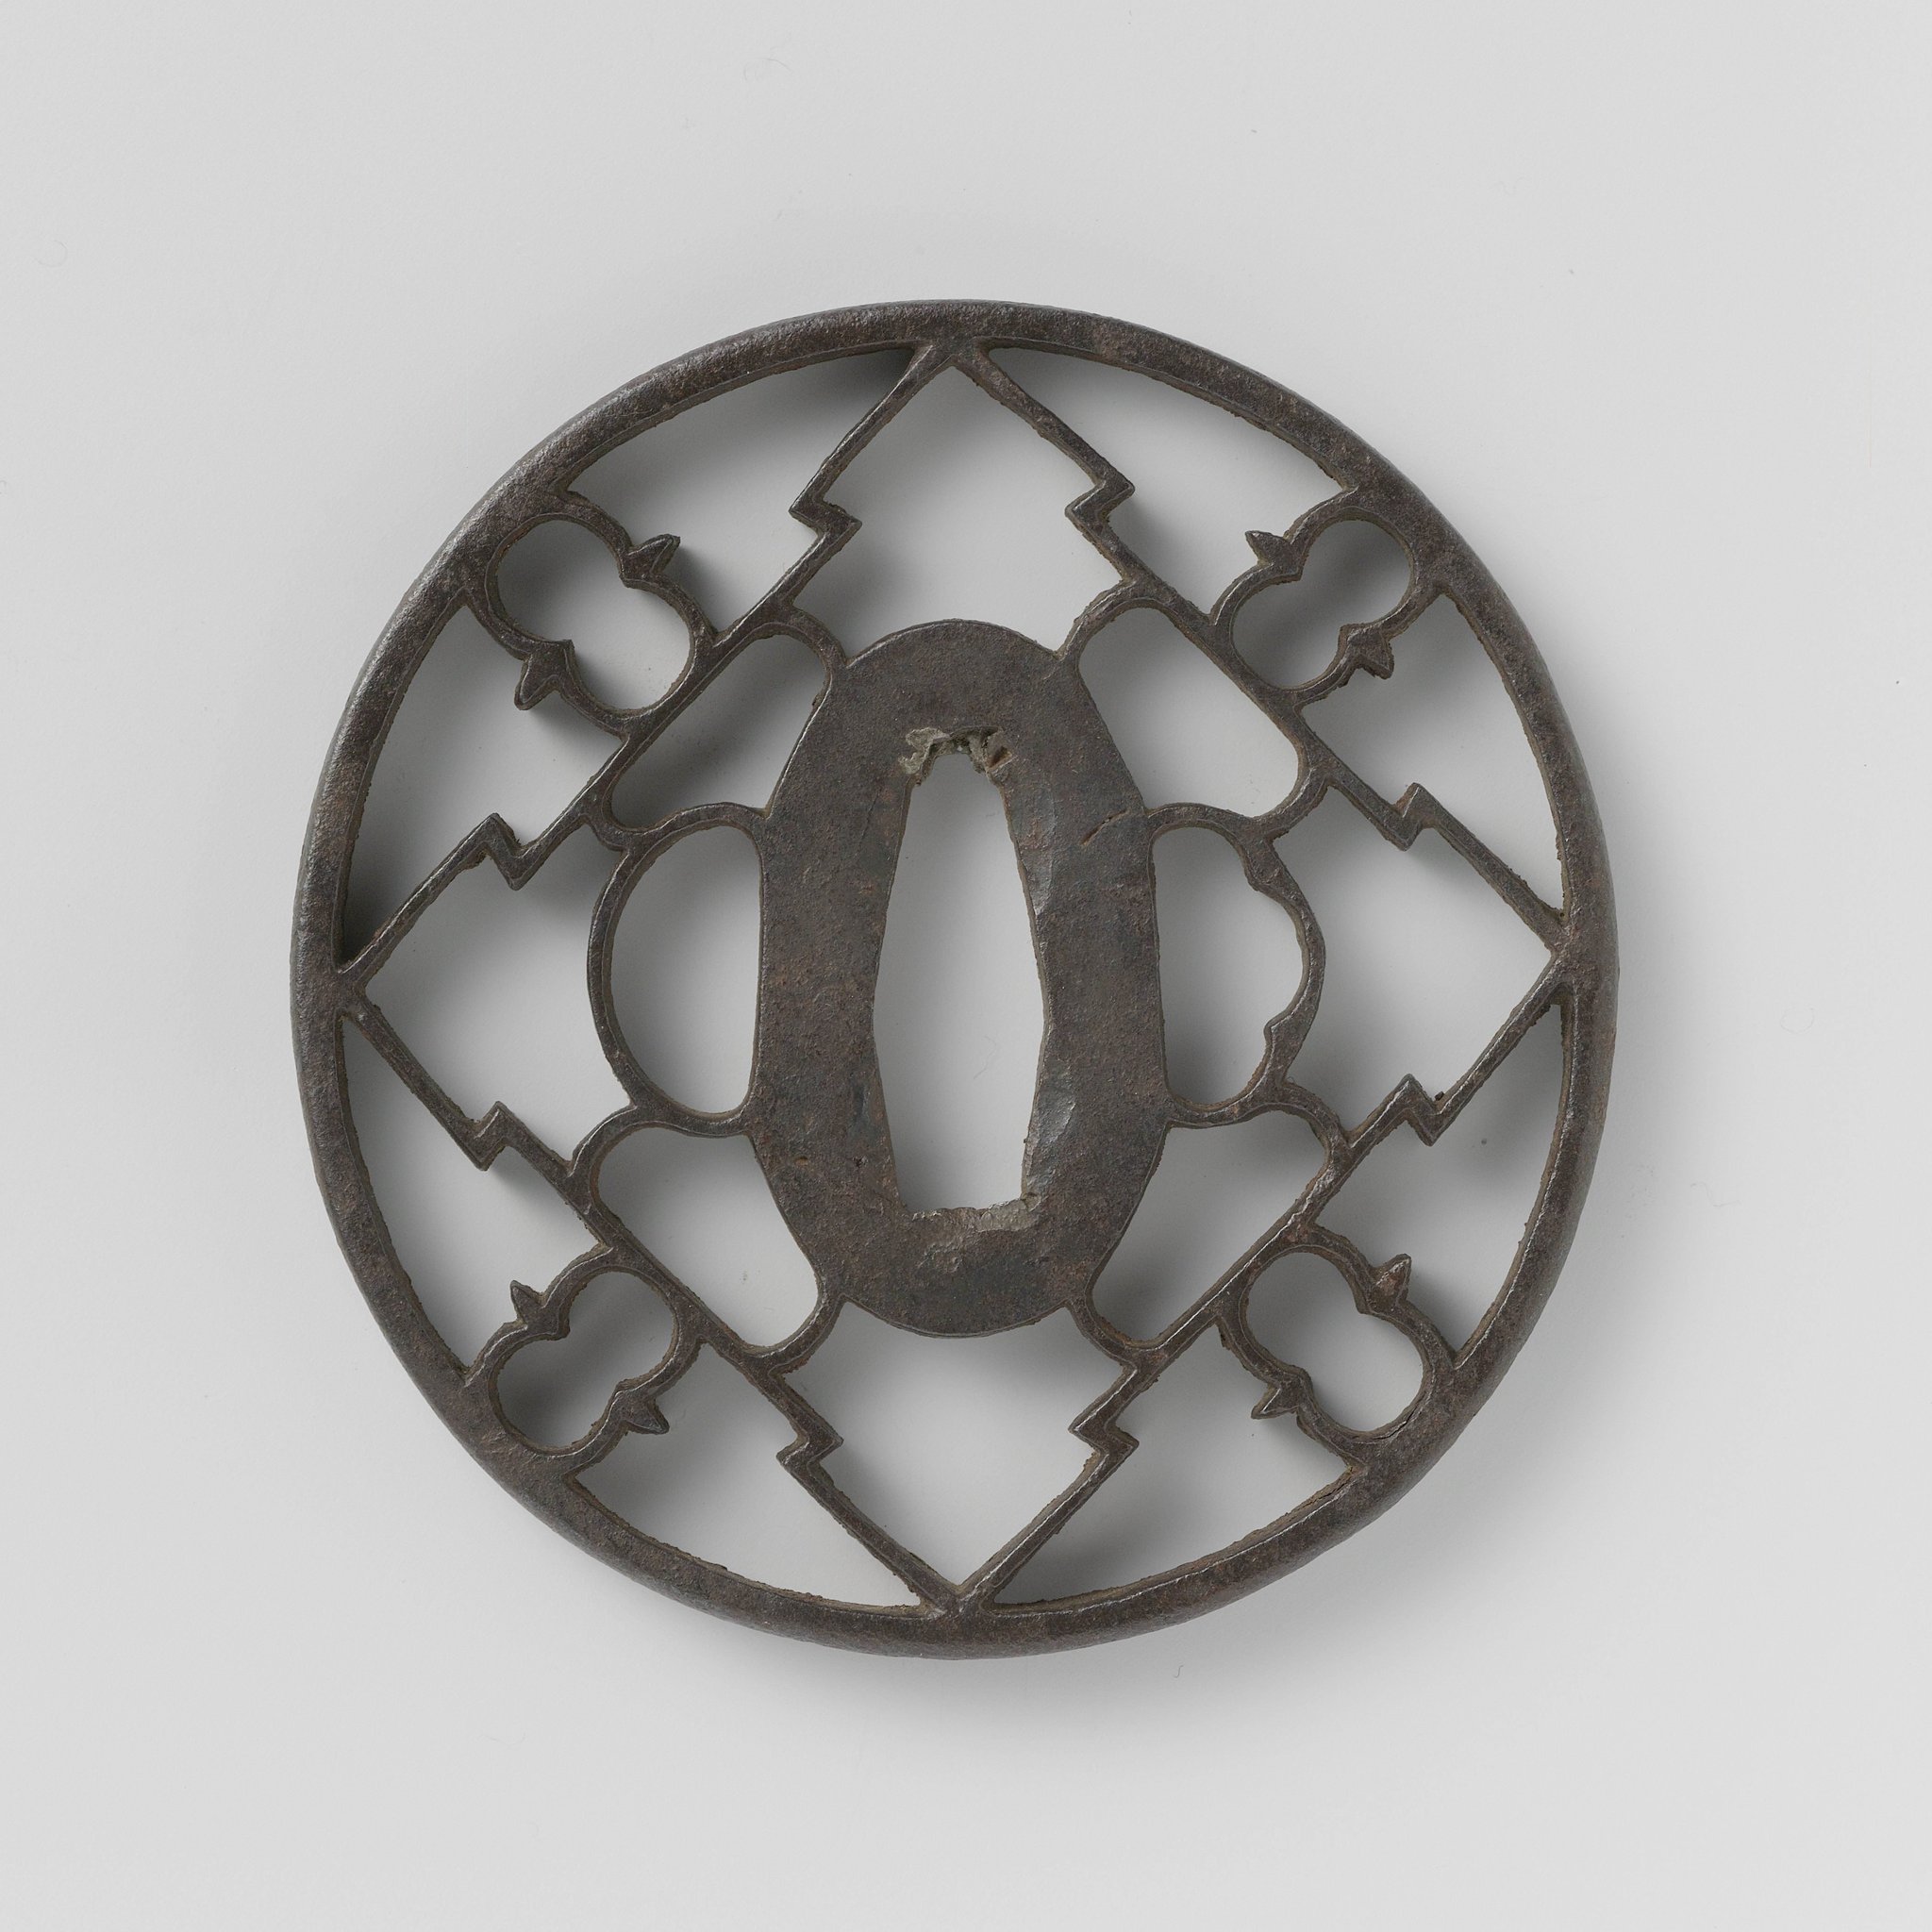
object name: tsuba, zwaardstootplaat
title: Hand guard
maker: Anonymous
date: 1600-1699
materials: iron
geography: japan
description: Tsuba with stylized geometrical pattern 18th century; iron. Westendorp bequest.